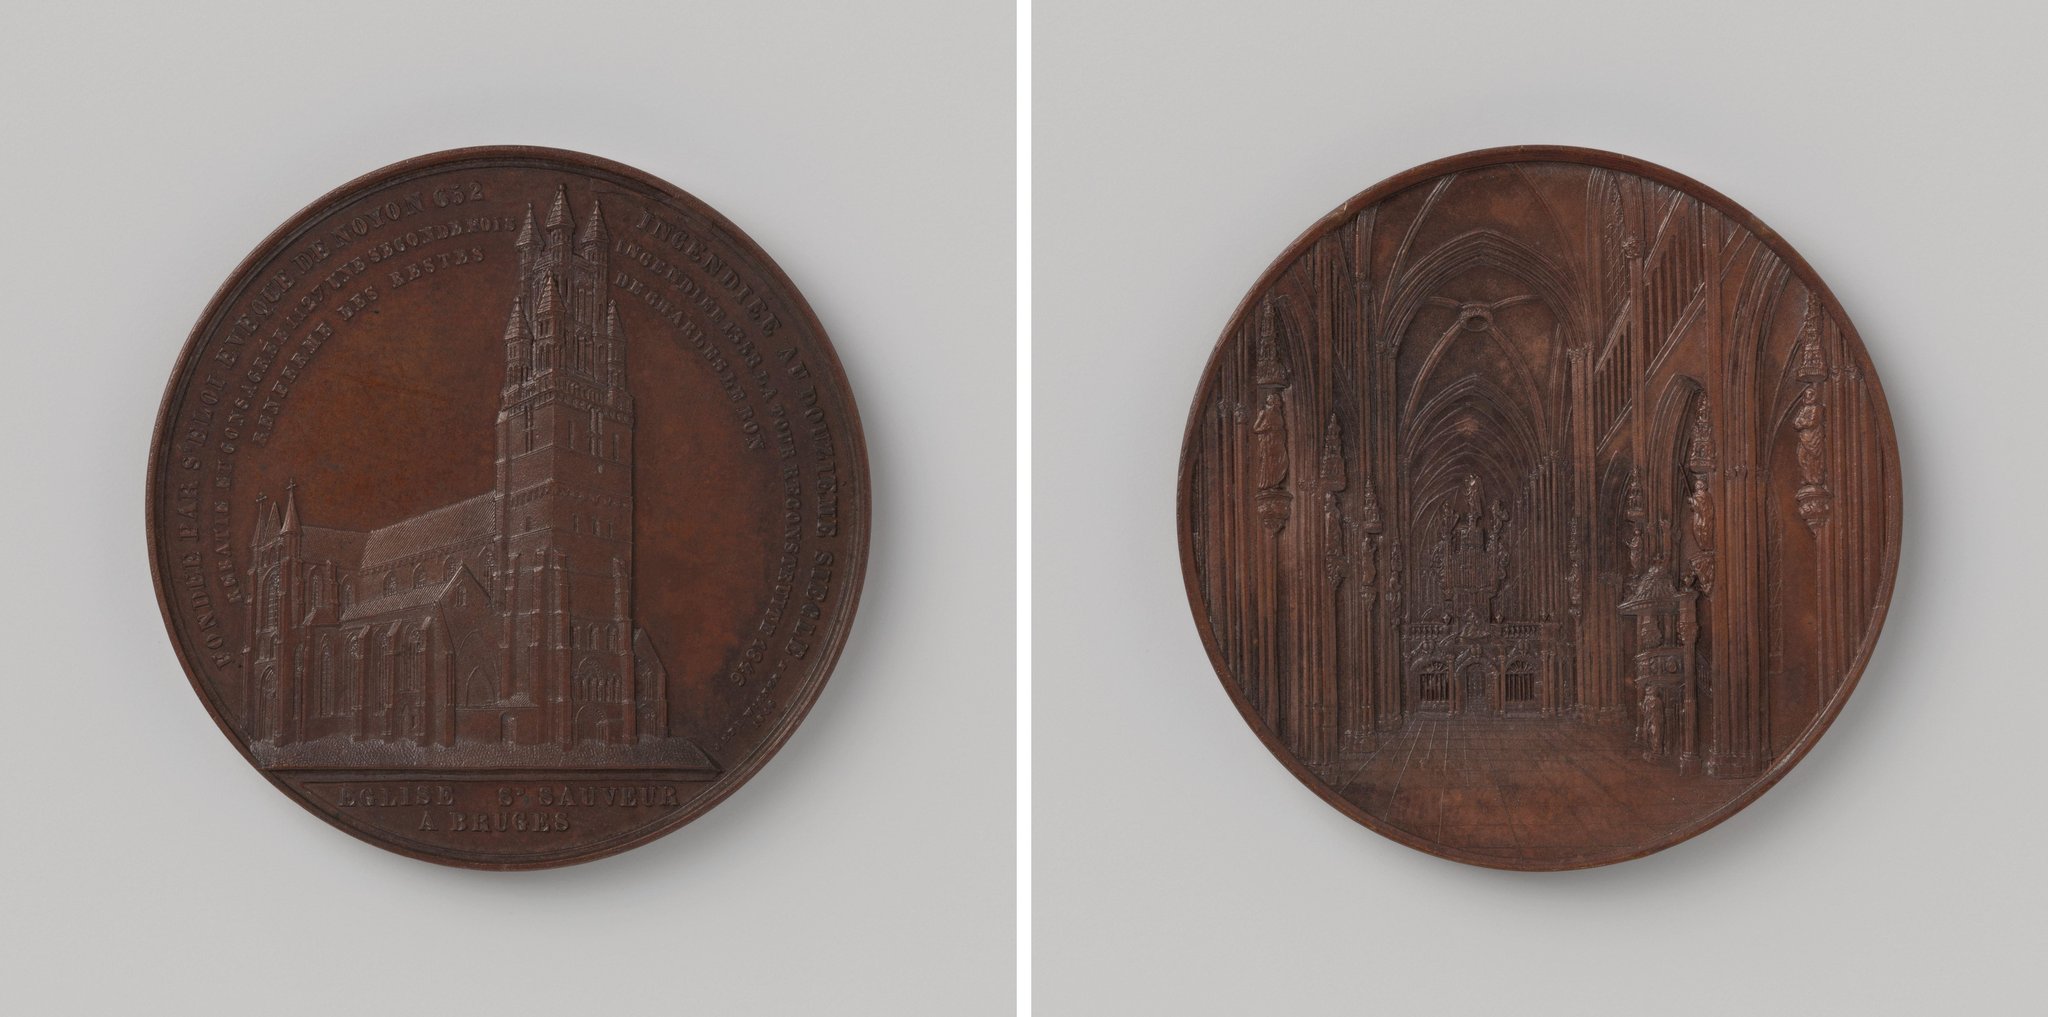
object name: history medal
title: St. Sauveur te Brugge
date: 1846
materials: bronze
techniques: striking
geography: brussels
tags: sint-salvatorskathedraal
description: Bronzen penning. Voorzijde: kerkgebouw binnen drieregelig omschrift; afsnede: opschrift. Keerzijde: interieur van kerk